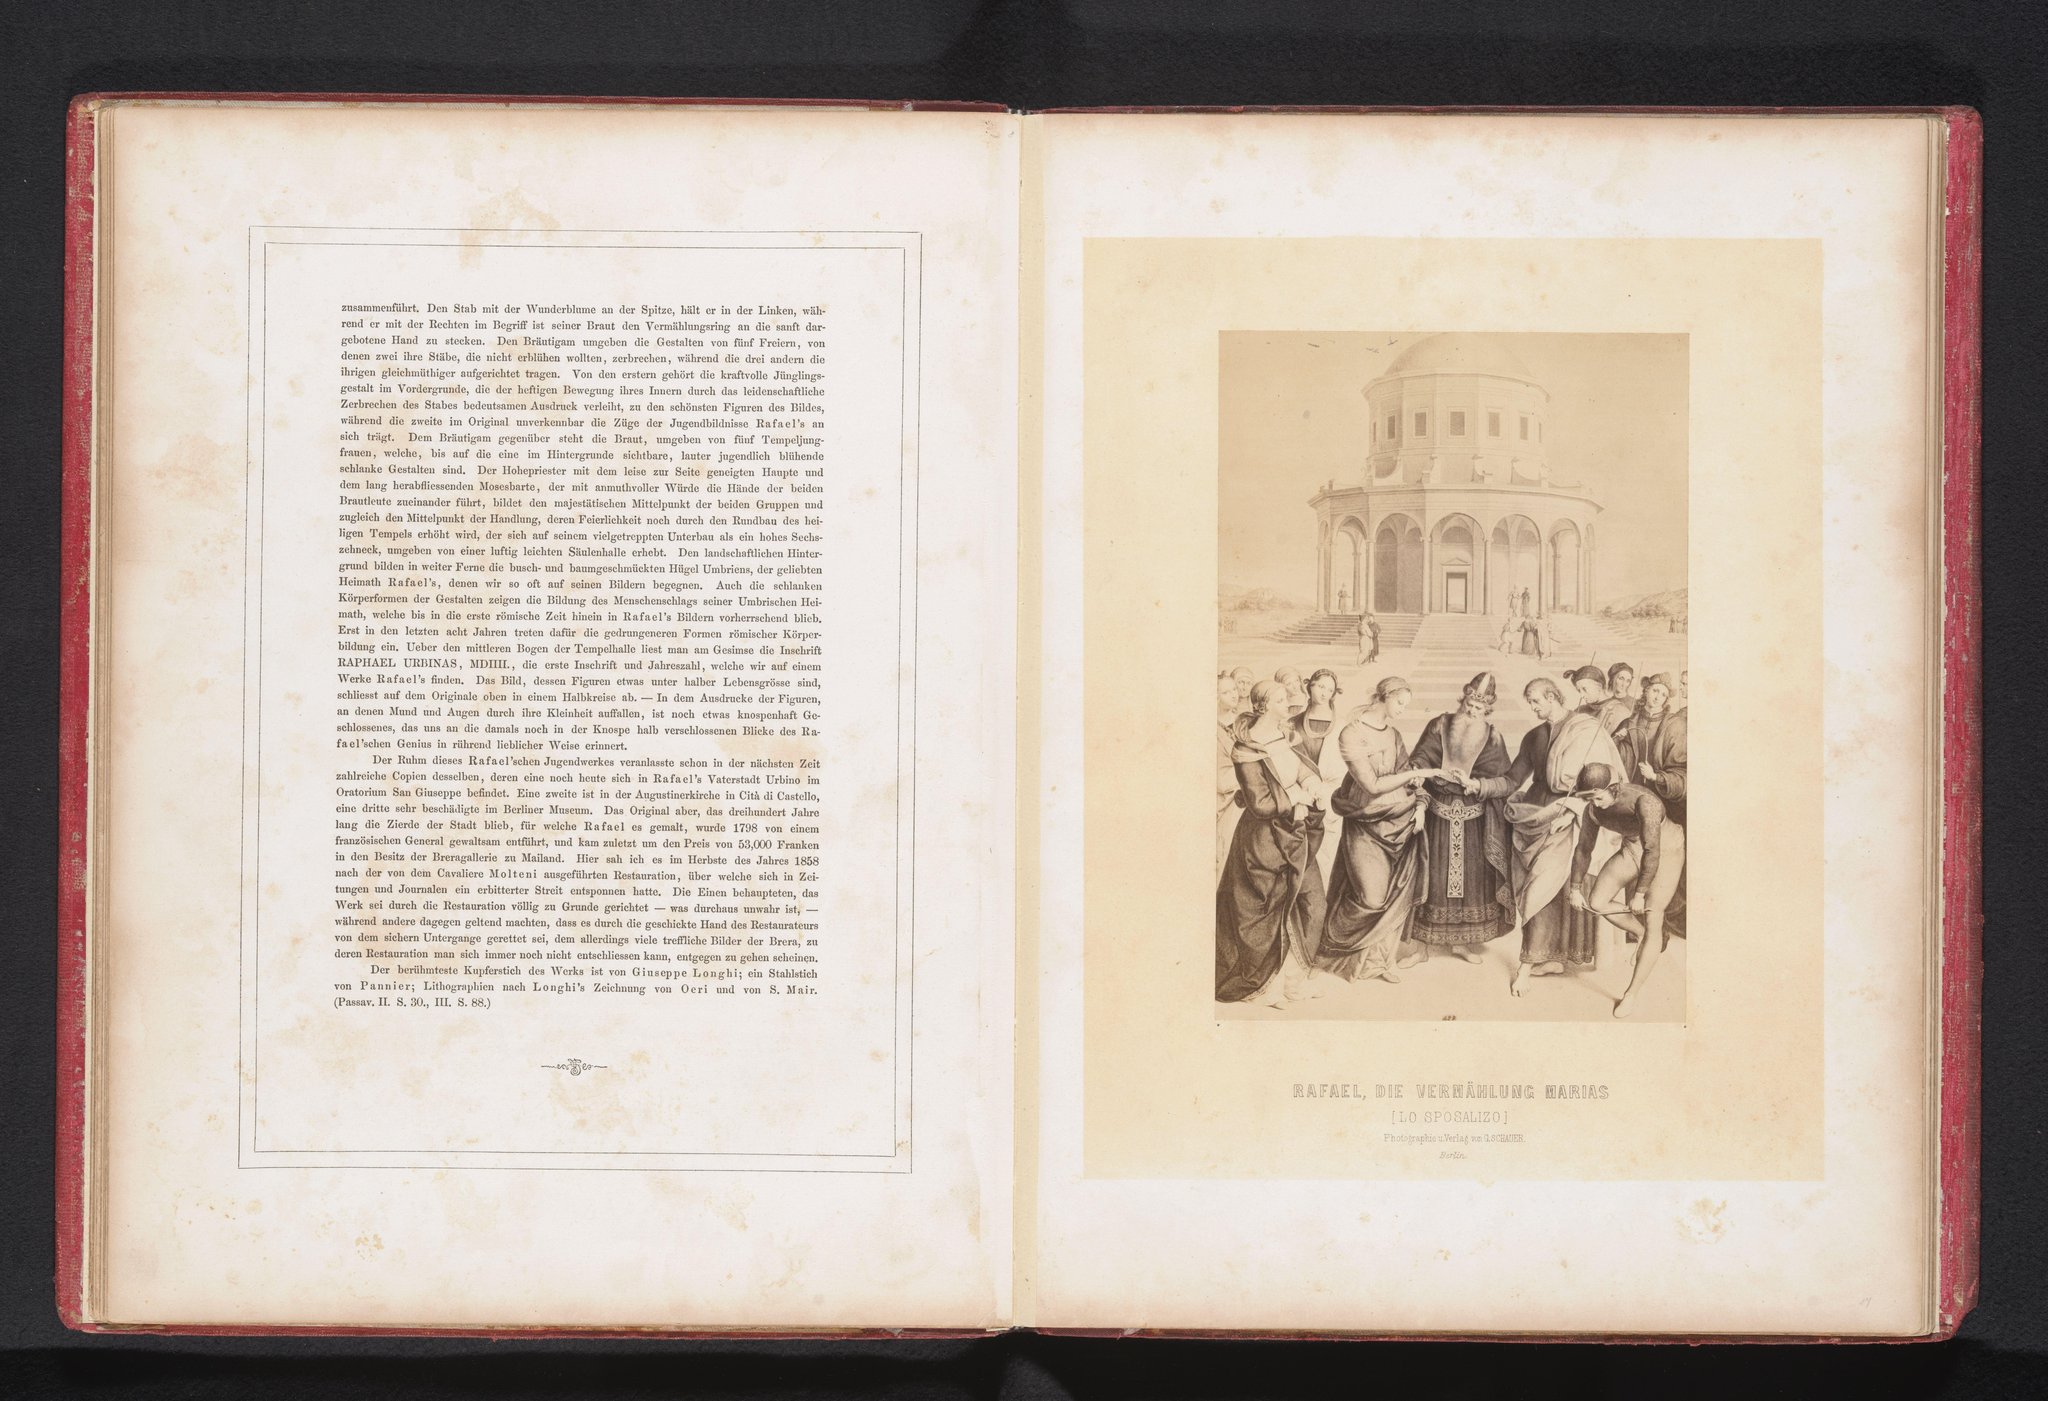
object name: photograph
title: Fotoreproductie van Het huwelijk van de Maagd Maria door Rafaël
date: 1851-1861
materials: photographic support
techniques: albumen print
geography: berlin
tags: marriage of mary and joseph, 'sposalizio': they are married by the high priest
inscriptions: number: ‘427’